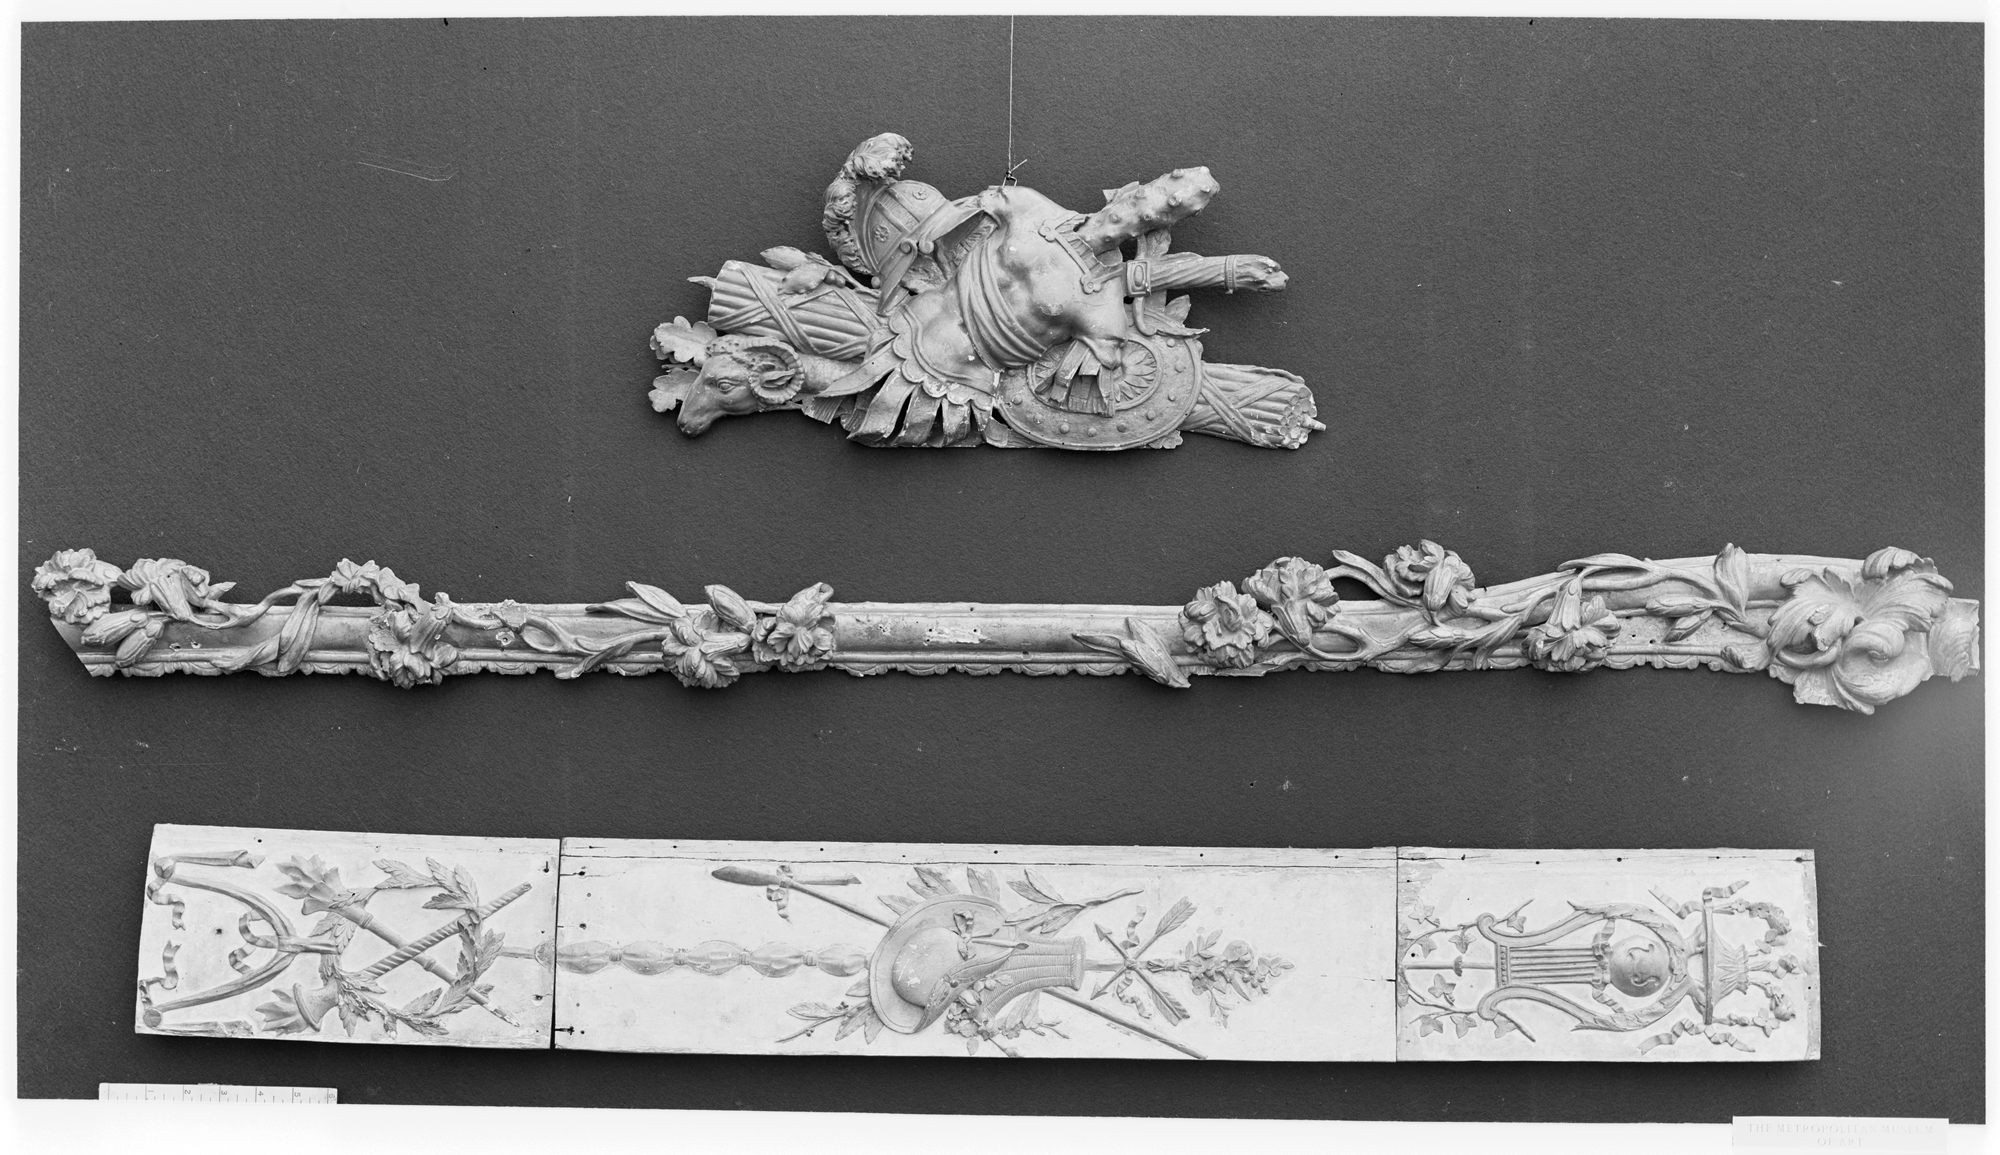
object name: frame fragment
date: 1701-1800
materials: wood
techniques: carving, gilding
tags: human figures,musical instruments,flowers